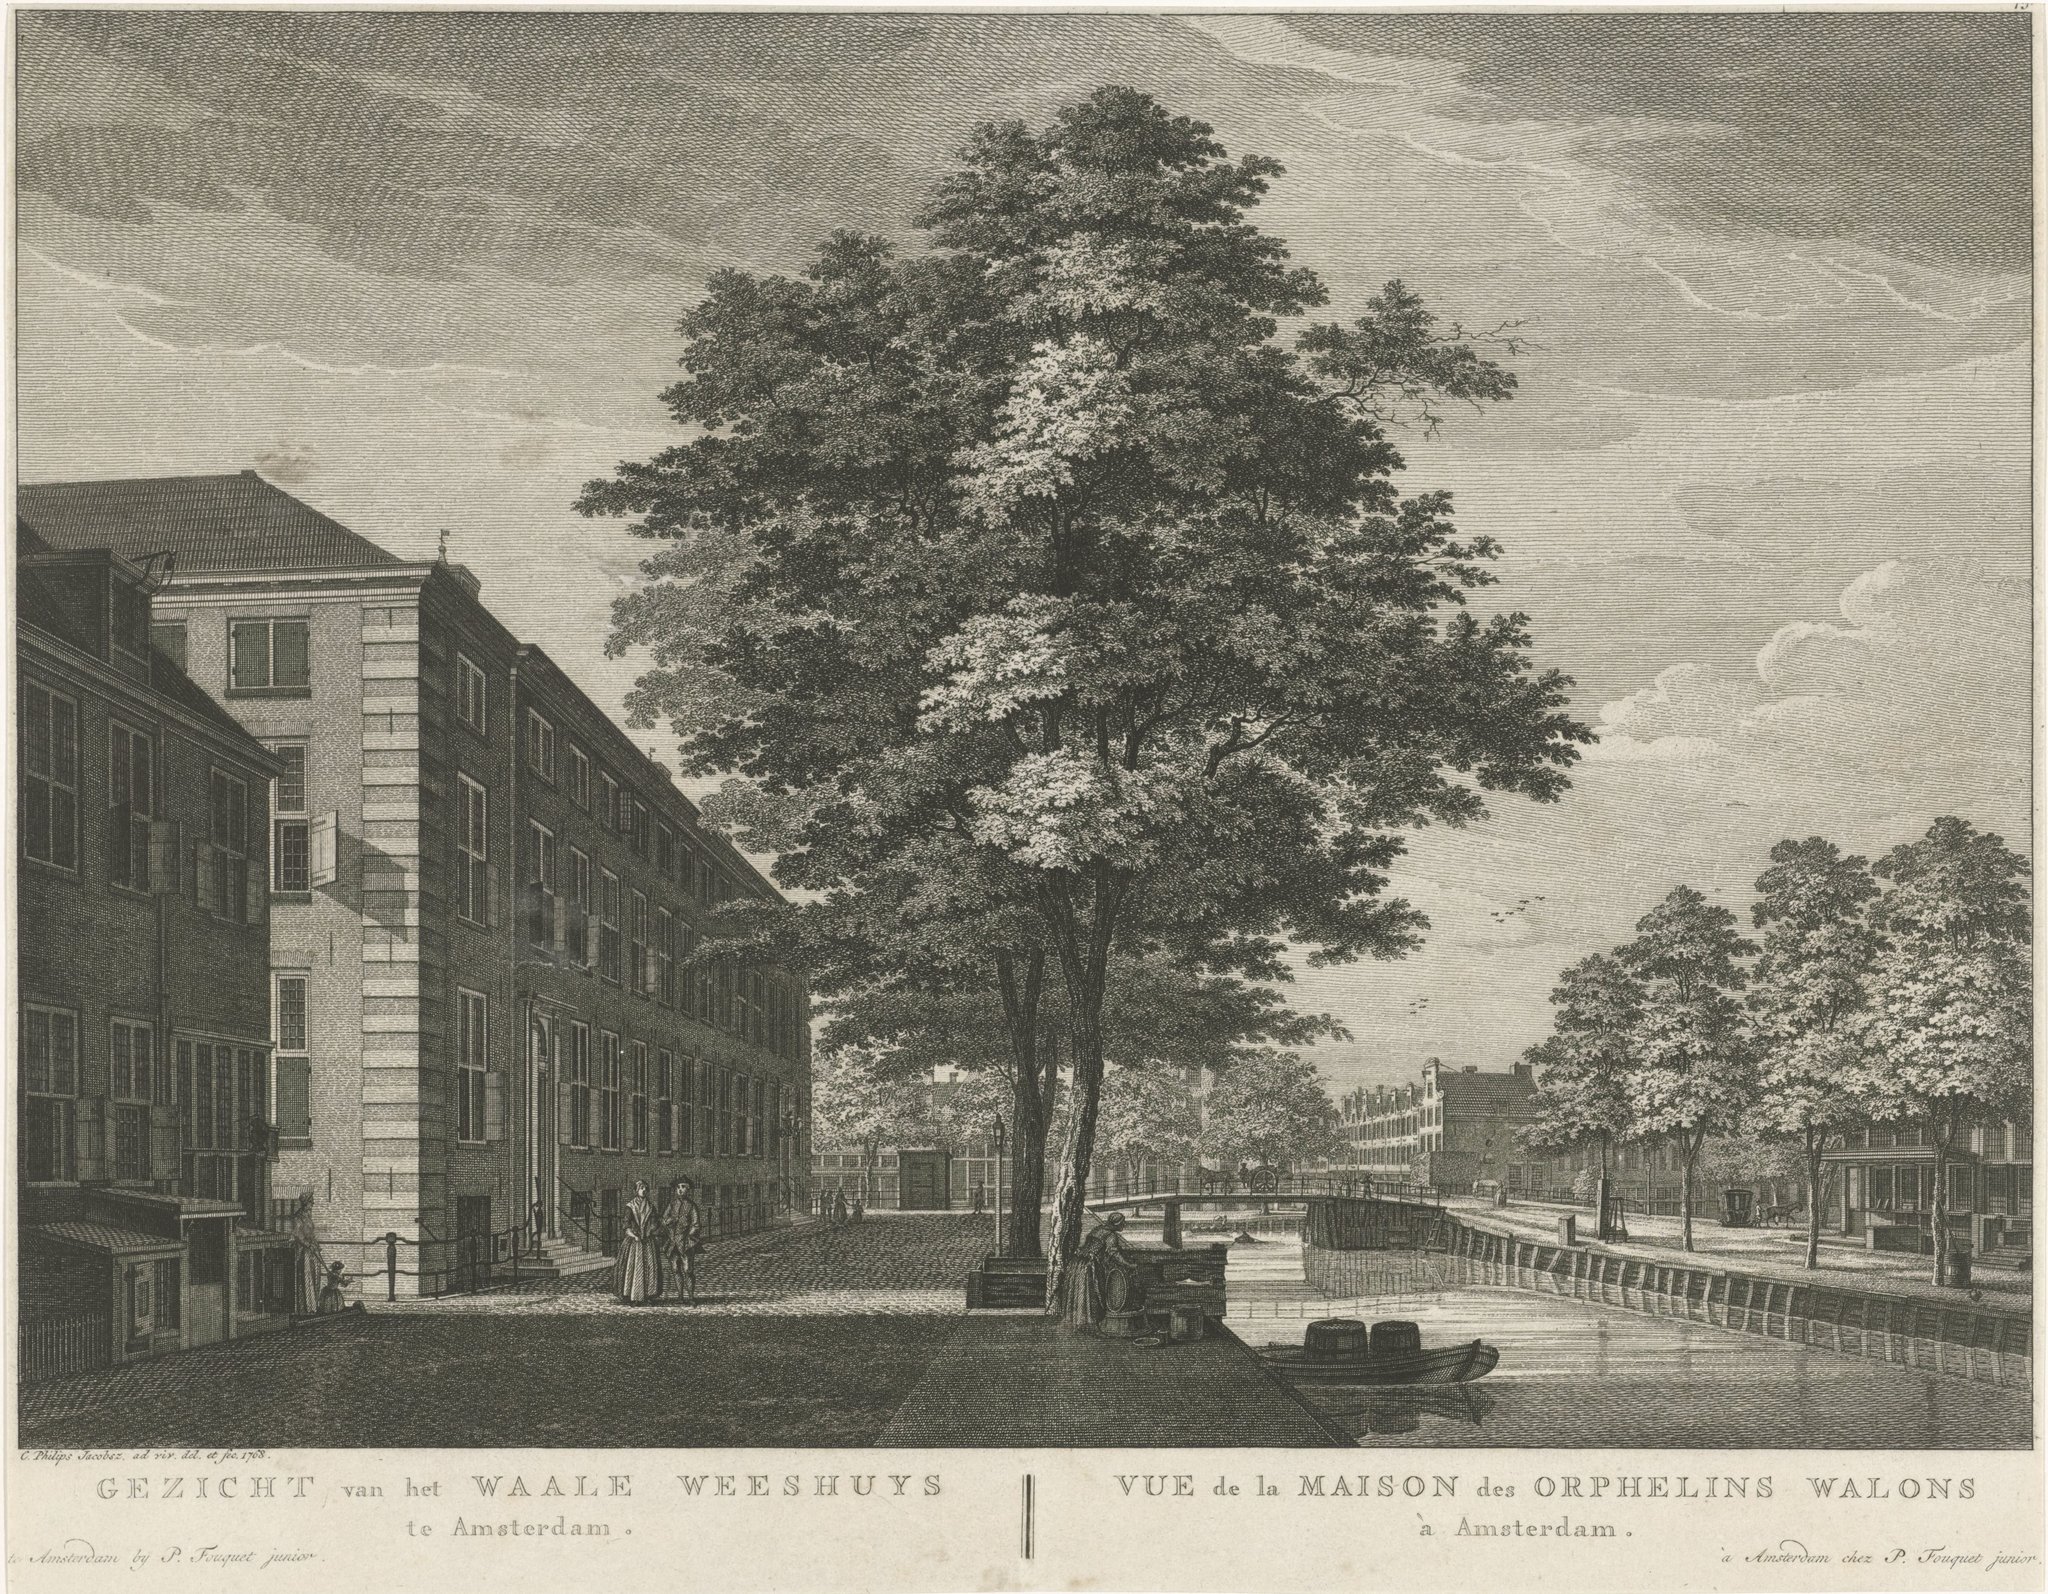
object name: print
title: Gezicht van het Waale Weeshuys te Amsterdam / Vue de la Maison des Orphelins Walons à Amsterdam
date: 1768-1783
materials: paper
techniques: engraving, etching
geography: amsterdam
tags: bridge in city across river, canal, etc. (+ city(-scape) with figures, staffage), orphanage, canals, waters (in city) (+ city(-scape) with figures, staffage), street (+ city(-scape) with figures, staffage)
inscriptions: collector's mark: Lugt 2228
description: Deze prent is ook gebruikt in de zogenaamde Atlas van Fouquet.* Pierre Fouquet gaf vanaf 1760 stadsgezichten van Amsterdam - naar tekeningen van verschillende kunstenaars, gemaakt door verschillende prentmakers - uit. Deze prenten werden aanvankelijk los of in series verkocht. Zoals toen gebruikelijk kon de koper de prenten zelf laten inbinden. Hiertoe gaf Fouquet tussen 1778 en 1783 een titelblad, plattegrond en inhoudsopgave van de tot dusver 100 uitgegeven prenten uit (1). Gezien de inhoud afhankelijk was van wat de koper had verzameld verschilt de inhoud van de verschillende bewaarde Fouquetatlassen onder deze titel sterk. Ook zijn er exemplaren bekend waar tevens andere prenten aan zijn toegevoegd. Omdat er behoefte bleek aan uitleg bij de platen werd in 1783 een nieuwe versie van de atlas uitgegeven, aangevuld met tekst en twee prenten. De aangegeven volgorde veranderde maar de platen van de al eerder uitgegeven prenten bleven ongewijzigd. Deze uitgave werd in opdracht van Fouquet gedrukt bij Daniël Jean Changuion en Petrus den Hengst (2). Een tiental platen werd bijgewerkt en verscheen, met nieuw impressum, in het vervolg van Wagenaars geschiedenis van Amsterdam, uitgeven door Petrus Conradi en Folkert van der Plaats (3). Een aantal jaar na het overlijden van Fouquet kwam Evert Maaskamp met een nieuwe uitgave van de atlas, met verbeterde tekst en toevoeging van twee prenten. Op alle platen verwijderde hij het oude en liet hij zijn eigen impressum zetten (4). De huidige staat van de prent komt voor in exemplaren van de onder (1) en (2) genoemde werken. * Onder de Atlas van Fouquet of Fouquetatlas verstaan we de hieronder vermelde publicaties (1), (2) en (4). (1). Afbeeldingen van de wyd-vermaarde koopstad Amsterdam benevens des zelvs voornaamste gebouwen en gezigten alle naar het leeven getekend / Receuil des edifices les plus considerables et des plus belles vues, de la fameuse ville d'Amsterdam, dessinées d'après nature. Amsterdam: Pierre Fouquet, 1778-1783. (2). Nieuwe atlas, van de voornaamste gebouwen en gezigten der stad Amsterdam, met derzelver beknopte beschryvingen. 2 delen. Amsterdam: Daniël Jean Changuion en Petrus den Hengst [in opdracht van Pierre Fouquet], 1783. (3). Stijl, Simon. Amsterdam, in zyne geschiedenissen, voorregten, koophandel, gebouwen, kerkenstaat, schoolen, schutterye, gilden en regeeringe, beschreeven. Om te dienen ten vervolge op het werk van Jan Wagenaar (…). 10 delen. Amsterdam en Harlingen: Petrus Conradi en Folkert van der Plaats, 1788-1801. (4). Nieuwe atlas, van de voornaamste gebouwen en gezigten der stad Amsterdam. Met derzelver beknopte beschryvingen. Amsterdam: Evert Maaskamp, 1805. * Het aantal vermelde staten is gebaseerd op het aantal gevonden staten. Mogelijk zijn er meer staten van deze prent.